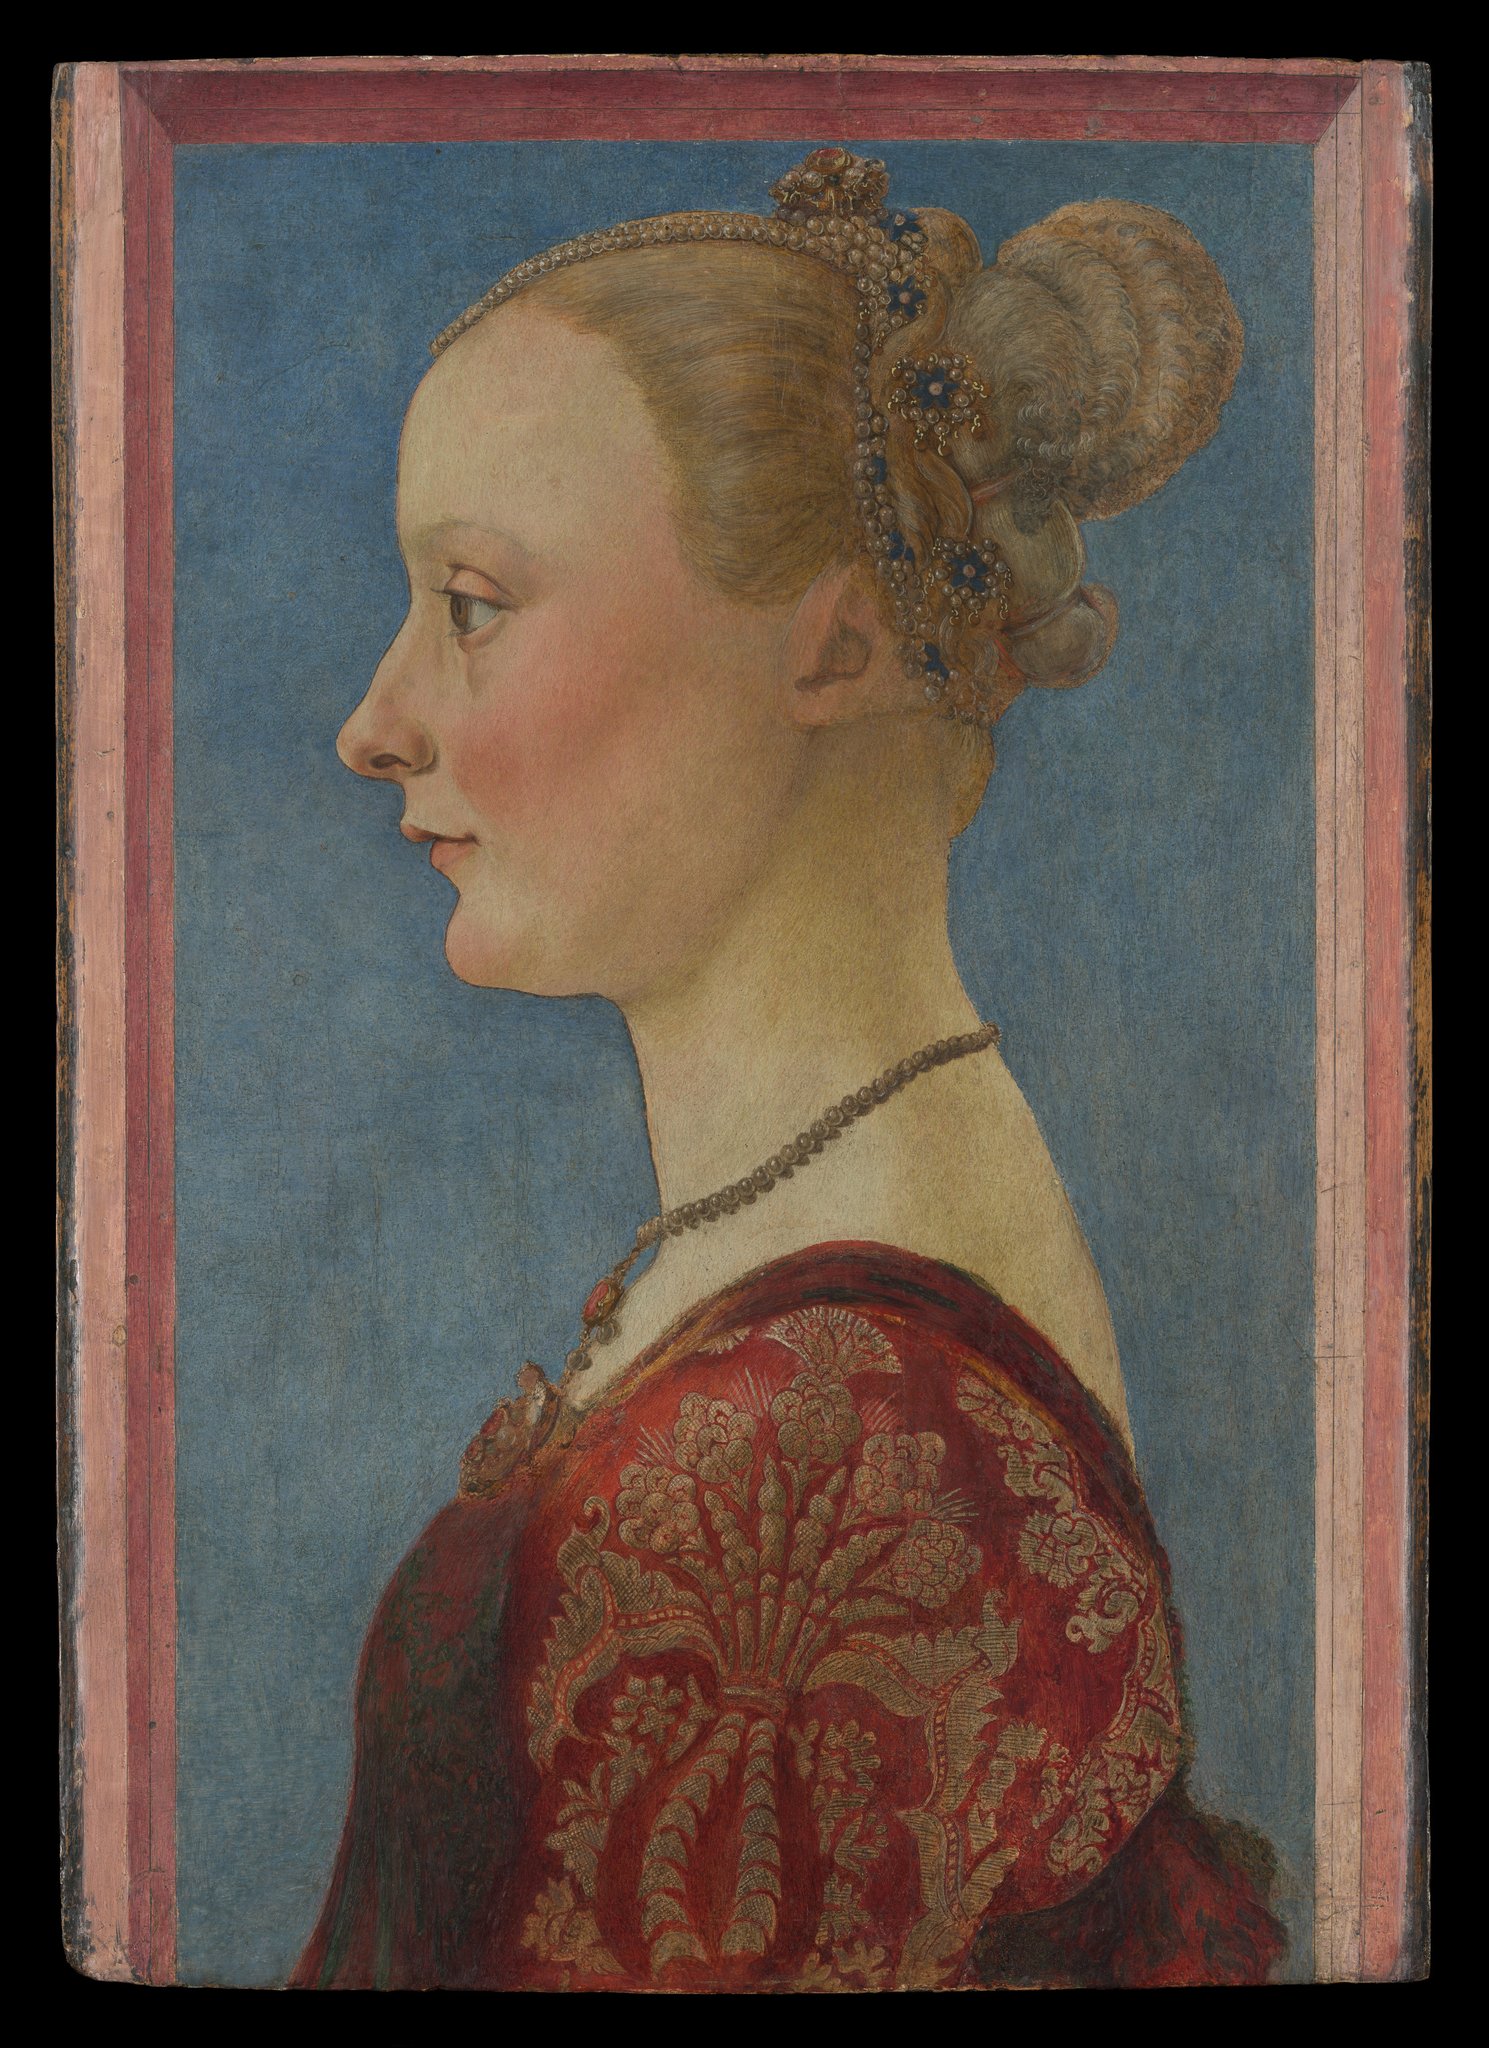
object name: painting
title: Portrait of a Woman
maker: piero del pollaiuolo (piero di jacopo benci)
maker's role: artist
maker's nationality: italian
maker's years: 1441-1496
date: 1480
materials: paint, wood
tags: portraits,profiles,women